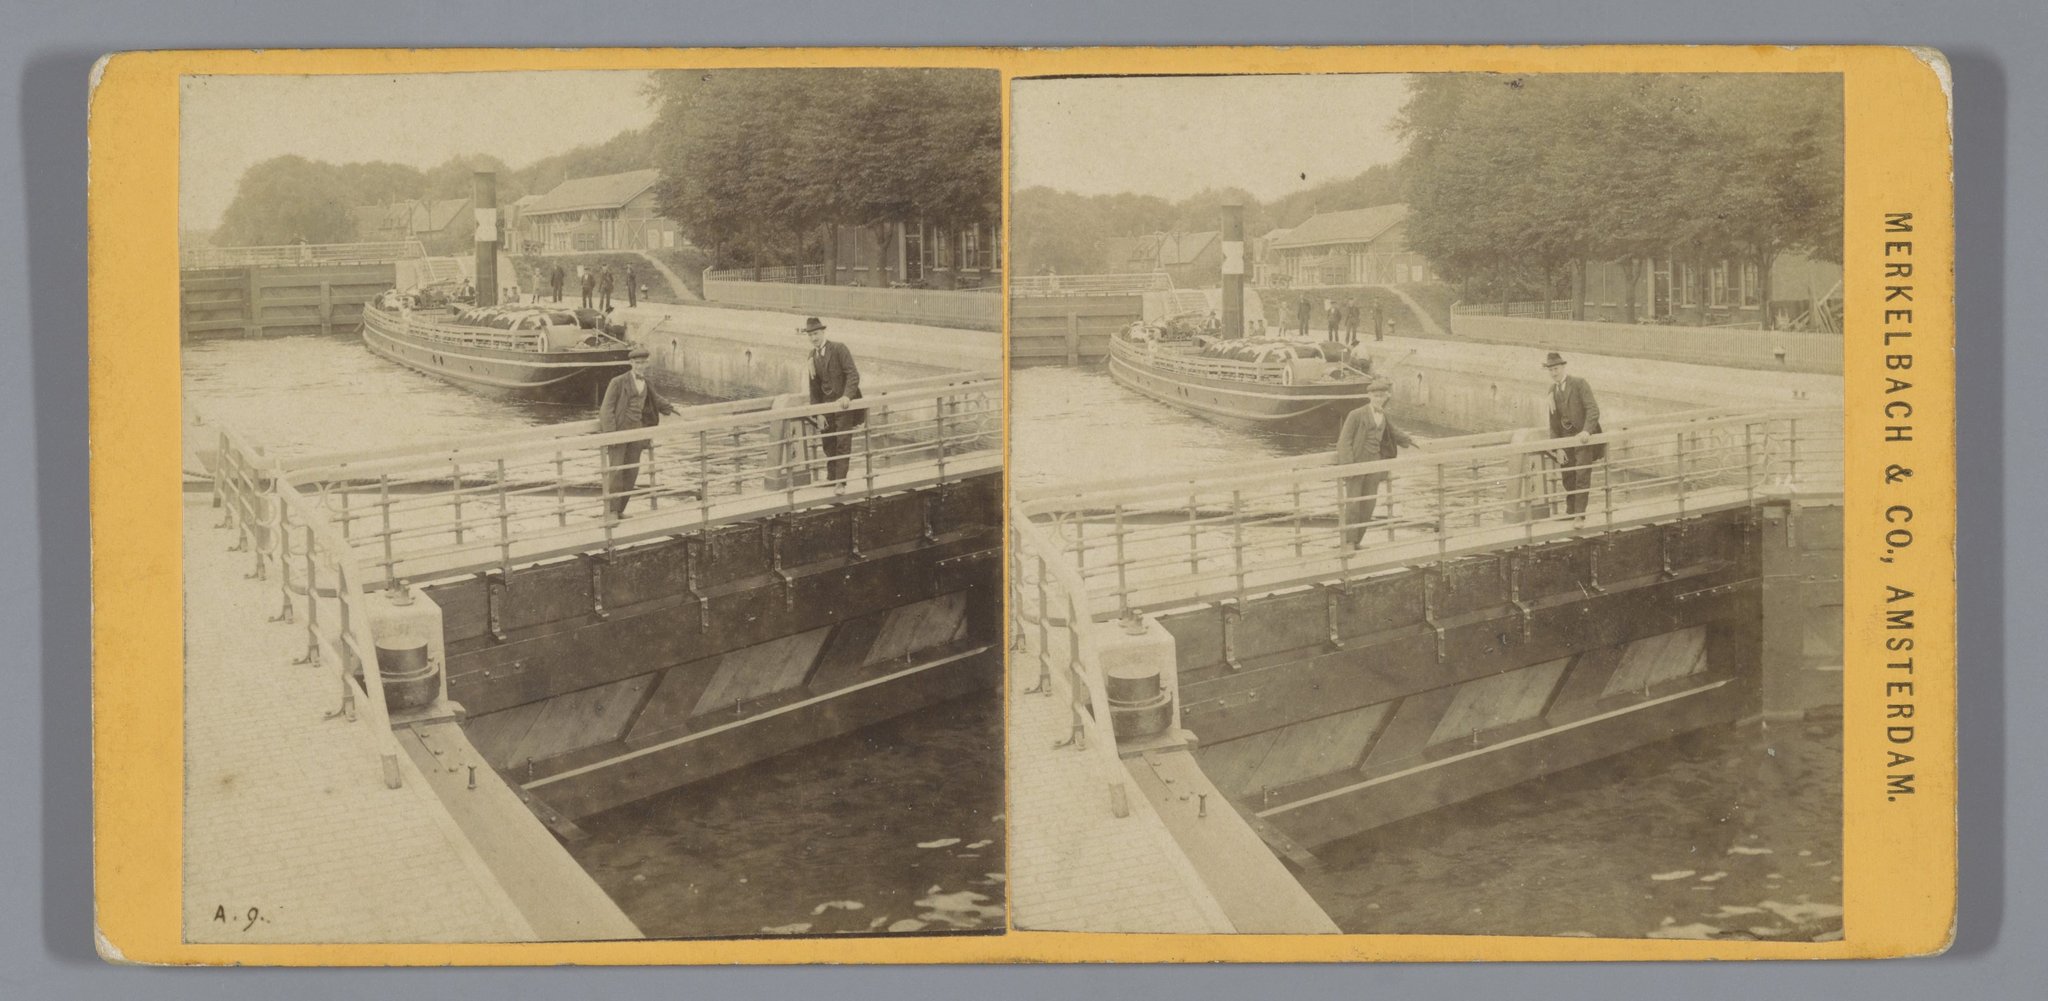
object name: stereograph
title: Schutsluis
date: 1900-1902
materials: cardboard, paper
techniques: albumen print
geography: amsterdam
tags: sluice, weir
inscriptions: inscription: ‘Willem I aan den ingang van het Groot Noordhollandsch Kanaal (...) geopend kunnen worden.’, number: ‘9.’, inscription: ‘A.9.’